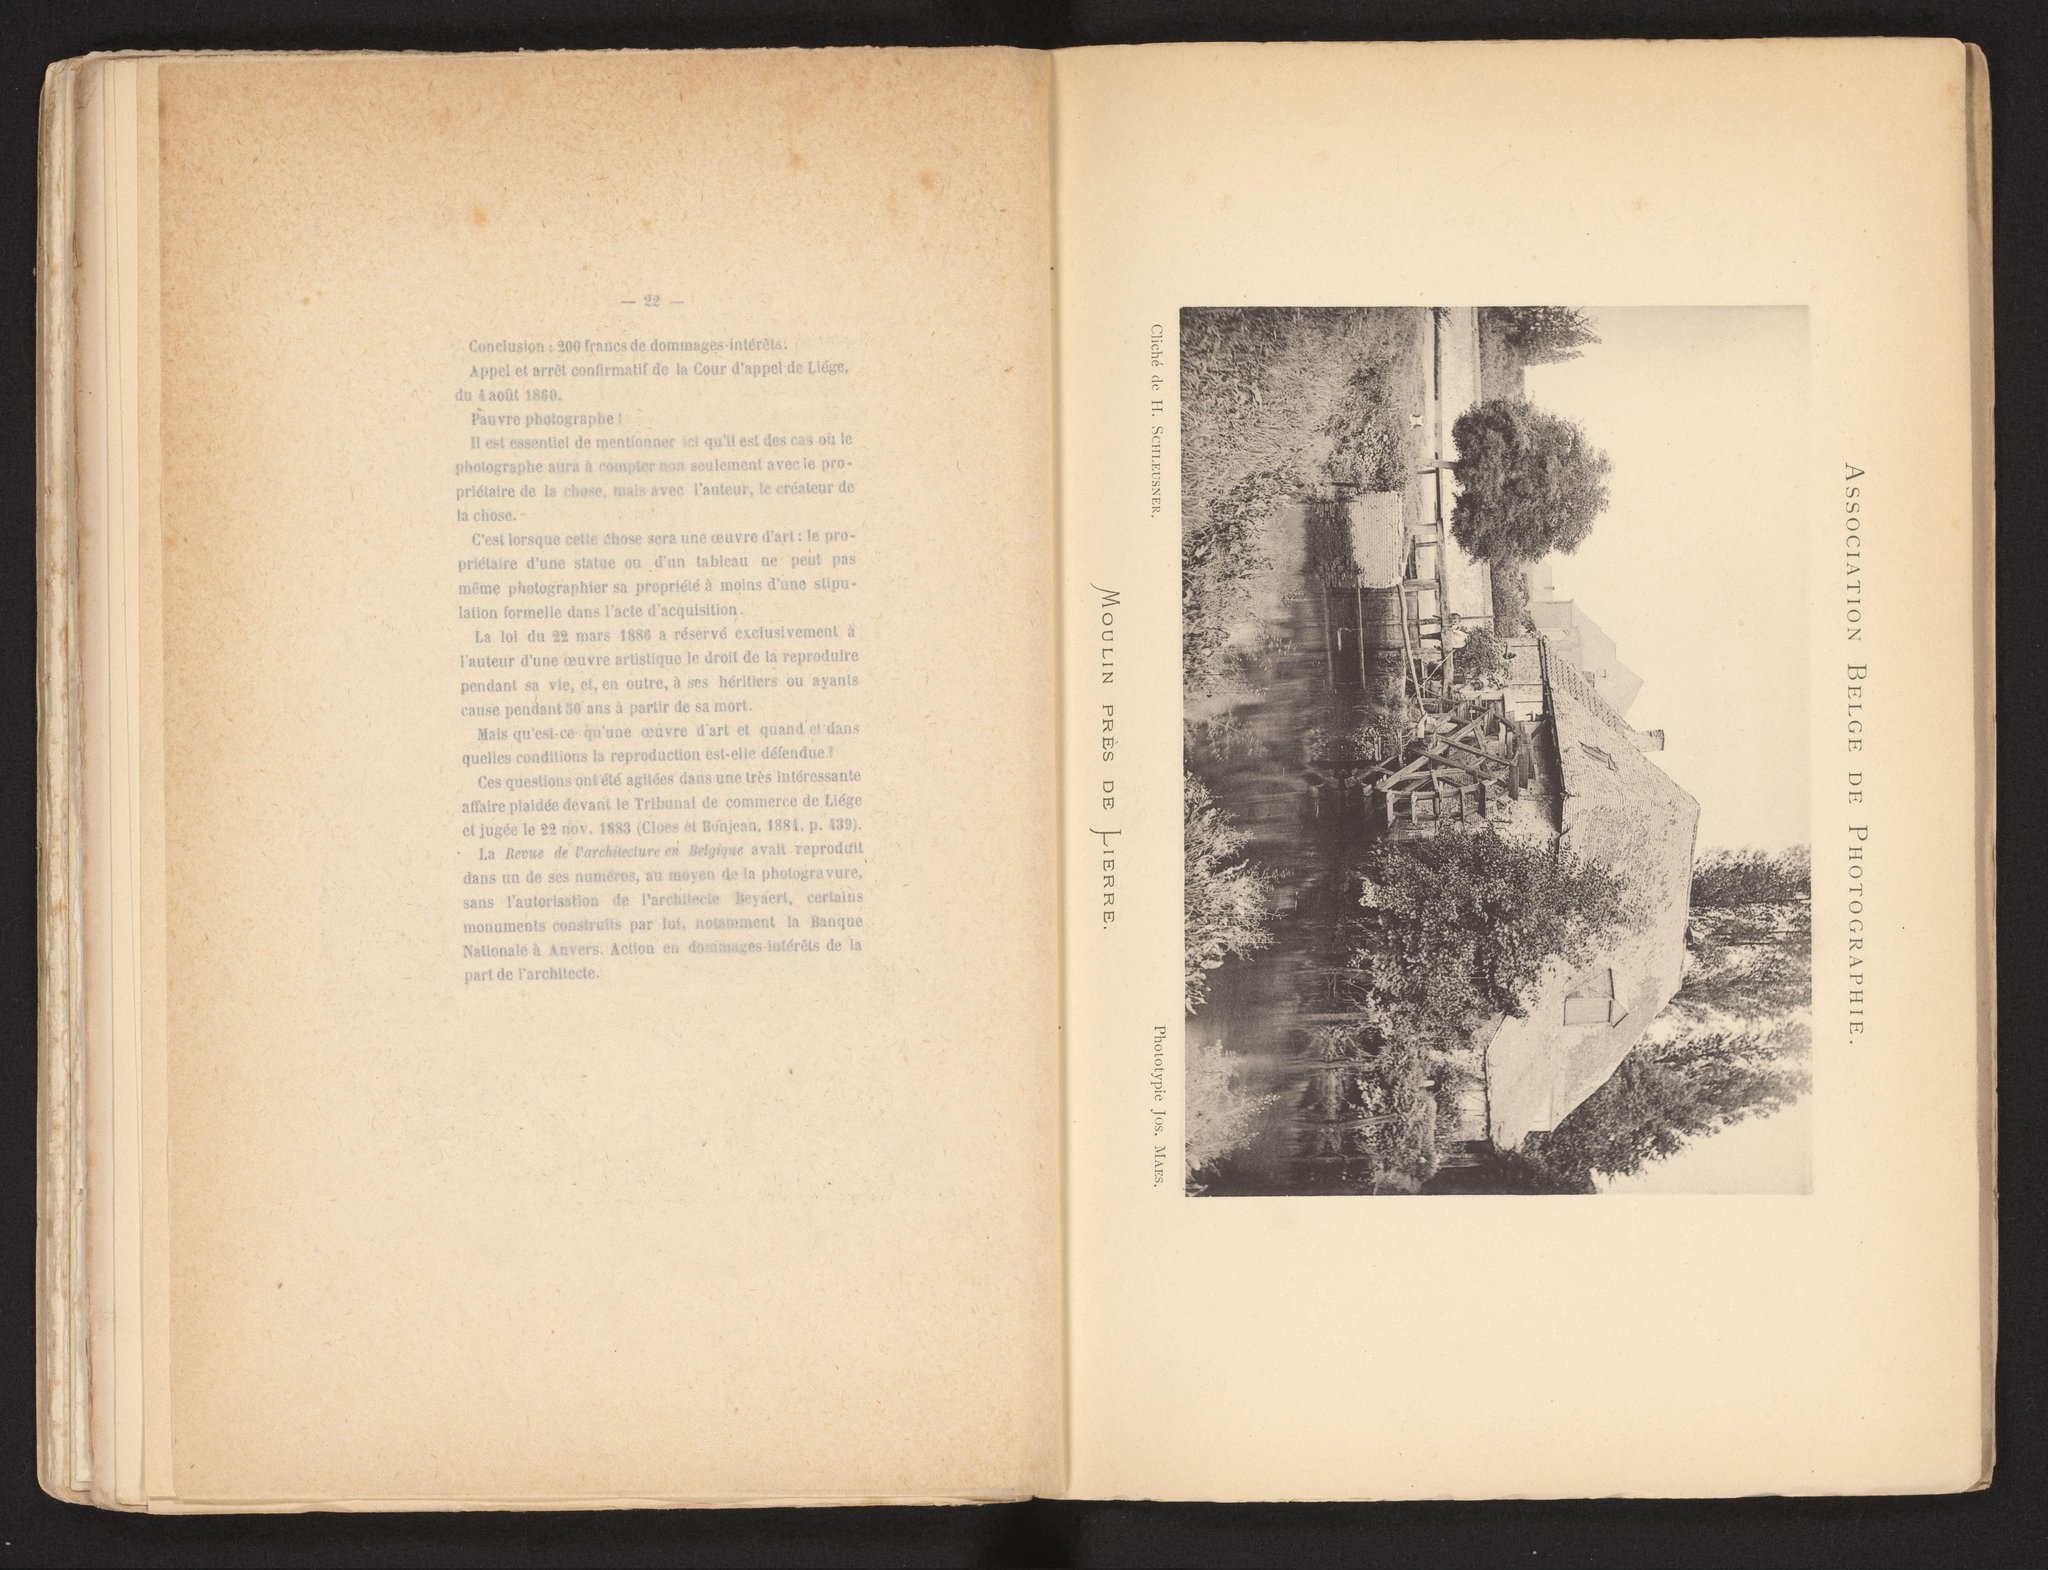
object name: page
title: Gezicht op een watermolen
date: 1885-1890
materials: paper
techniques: photograph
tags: landscapes with waters, waterscapes, seascapes (in the temperate zone), watermill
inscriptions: inscription: ‘Bulletin de l'Association belge de photographie’